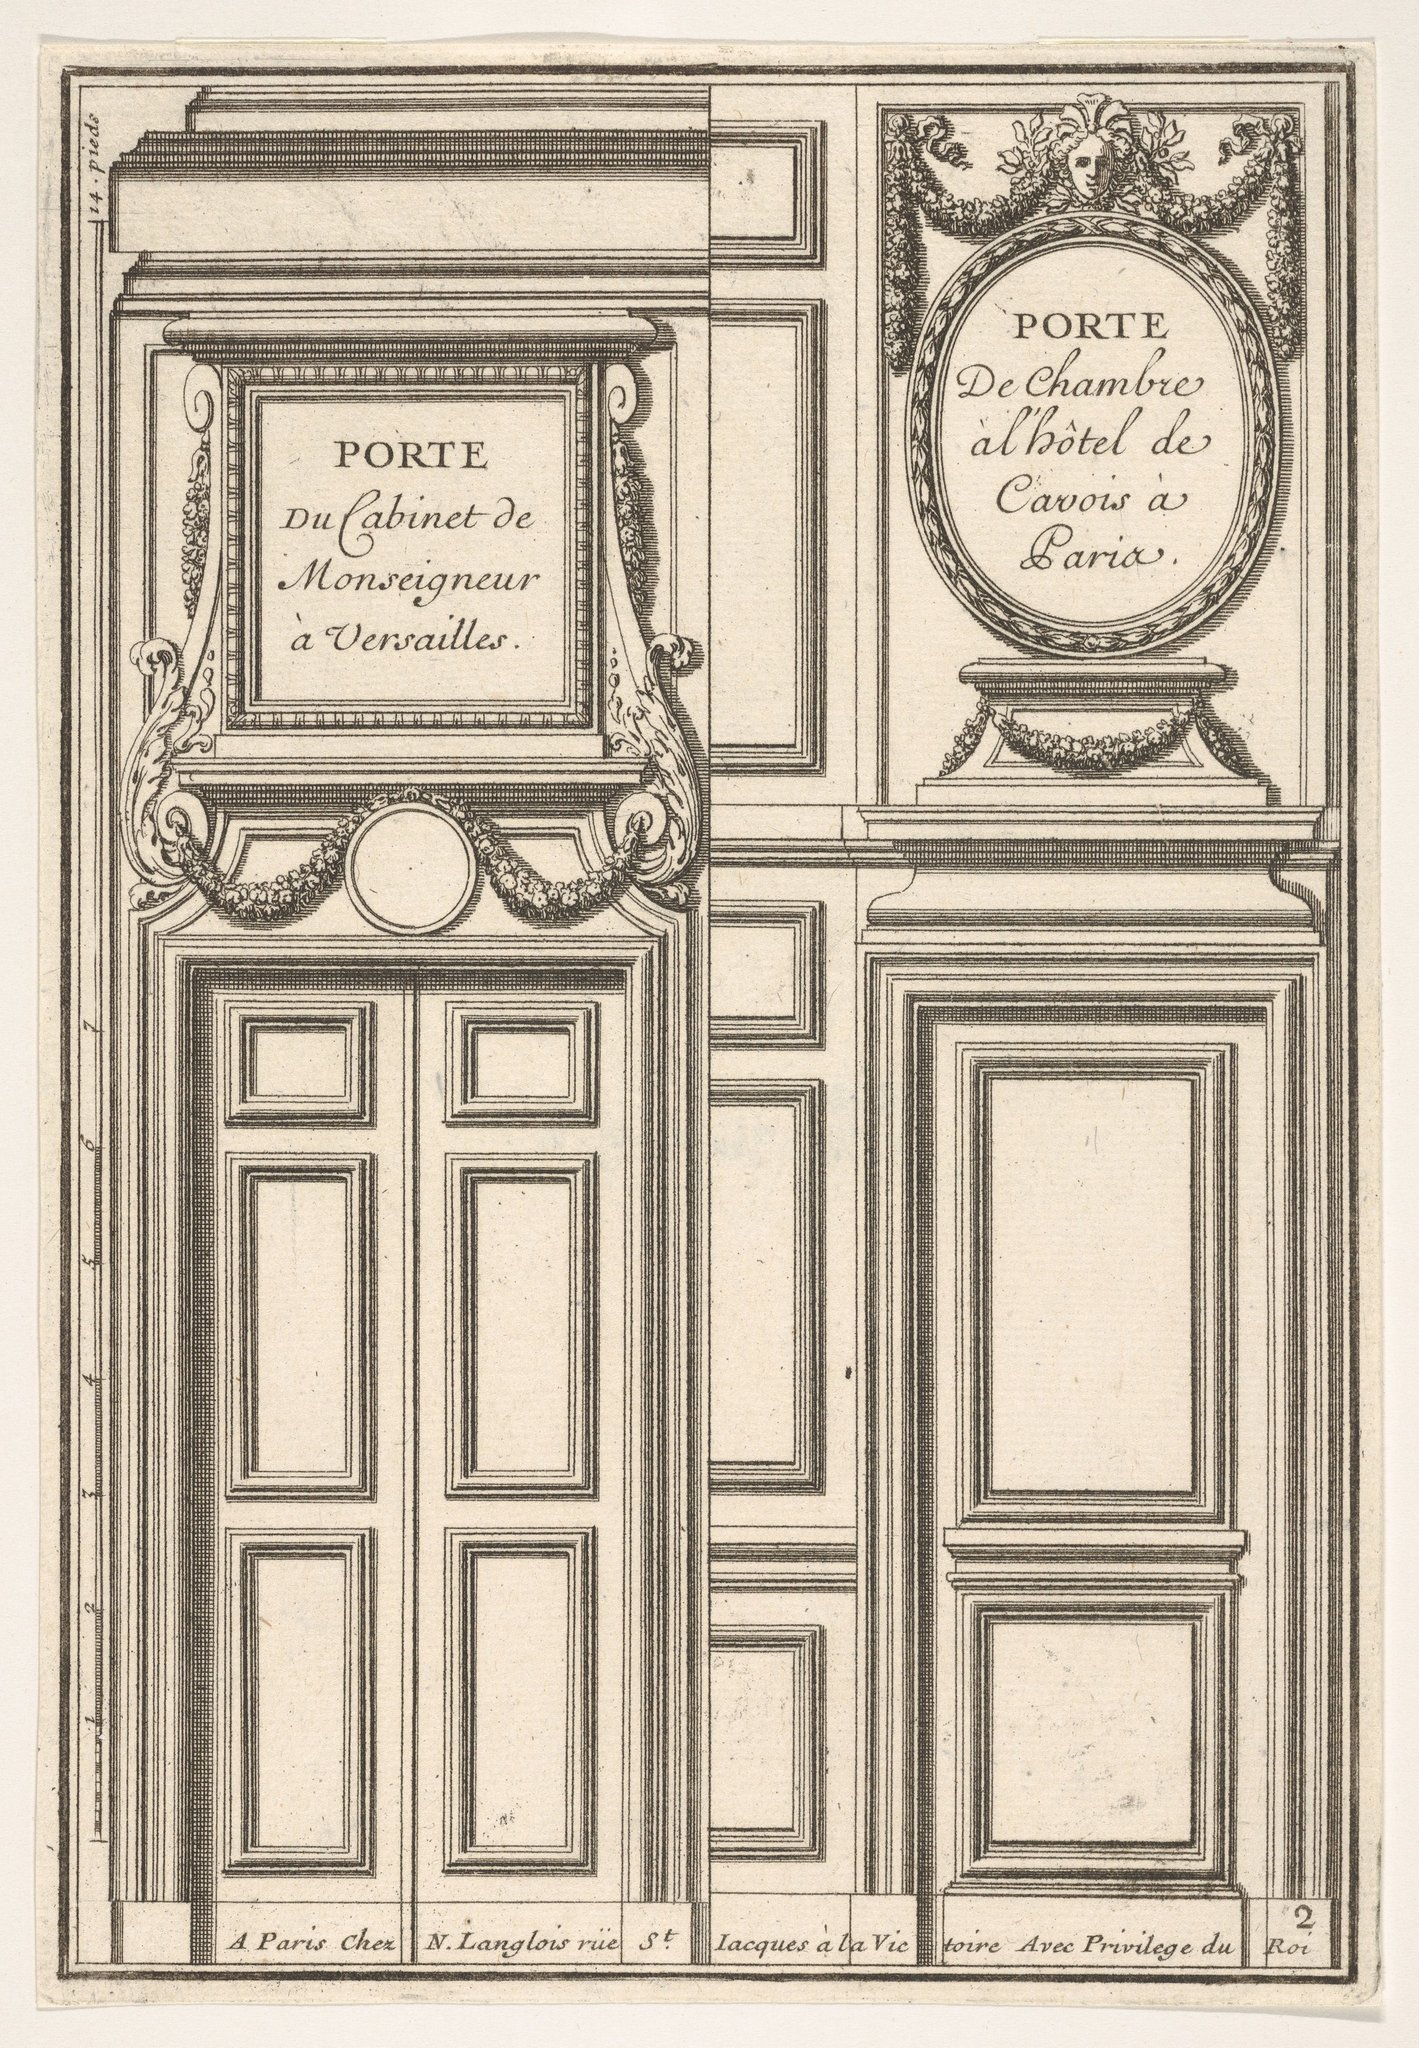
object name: print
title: Two Designs for Doors, one at Versailles and one at the Hotel Cavois in Paris, plate II from "Portes a Placard et Lambris'"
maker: jean le pautre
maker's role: etcher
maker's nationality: french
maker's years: 1618-1682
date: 1601-1700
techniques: etching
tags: doors